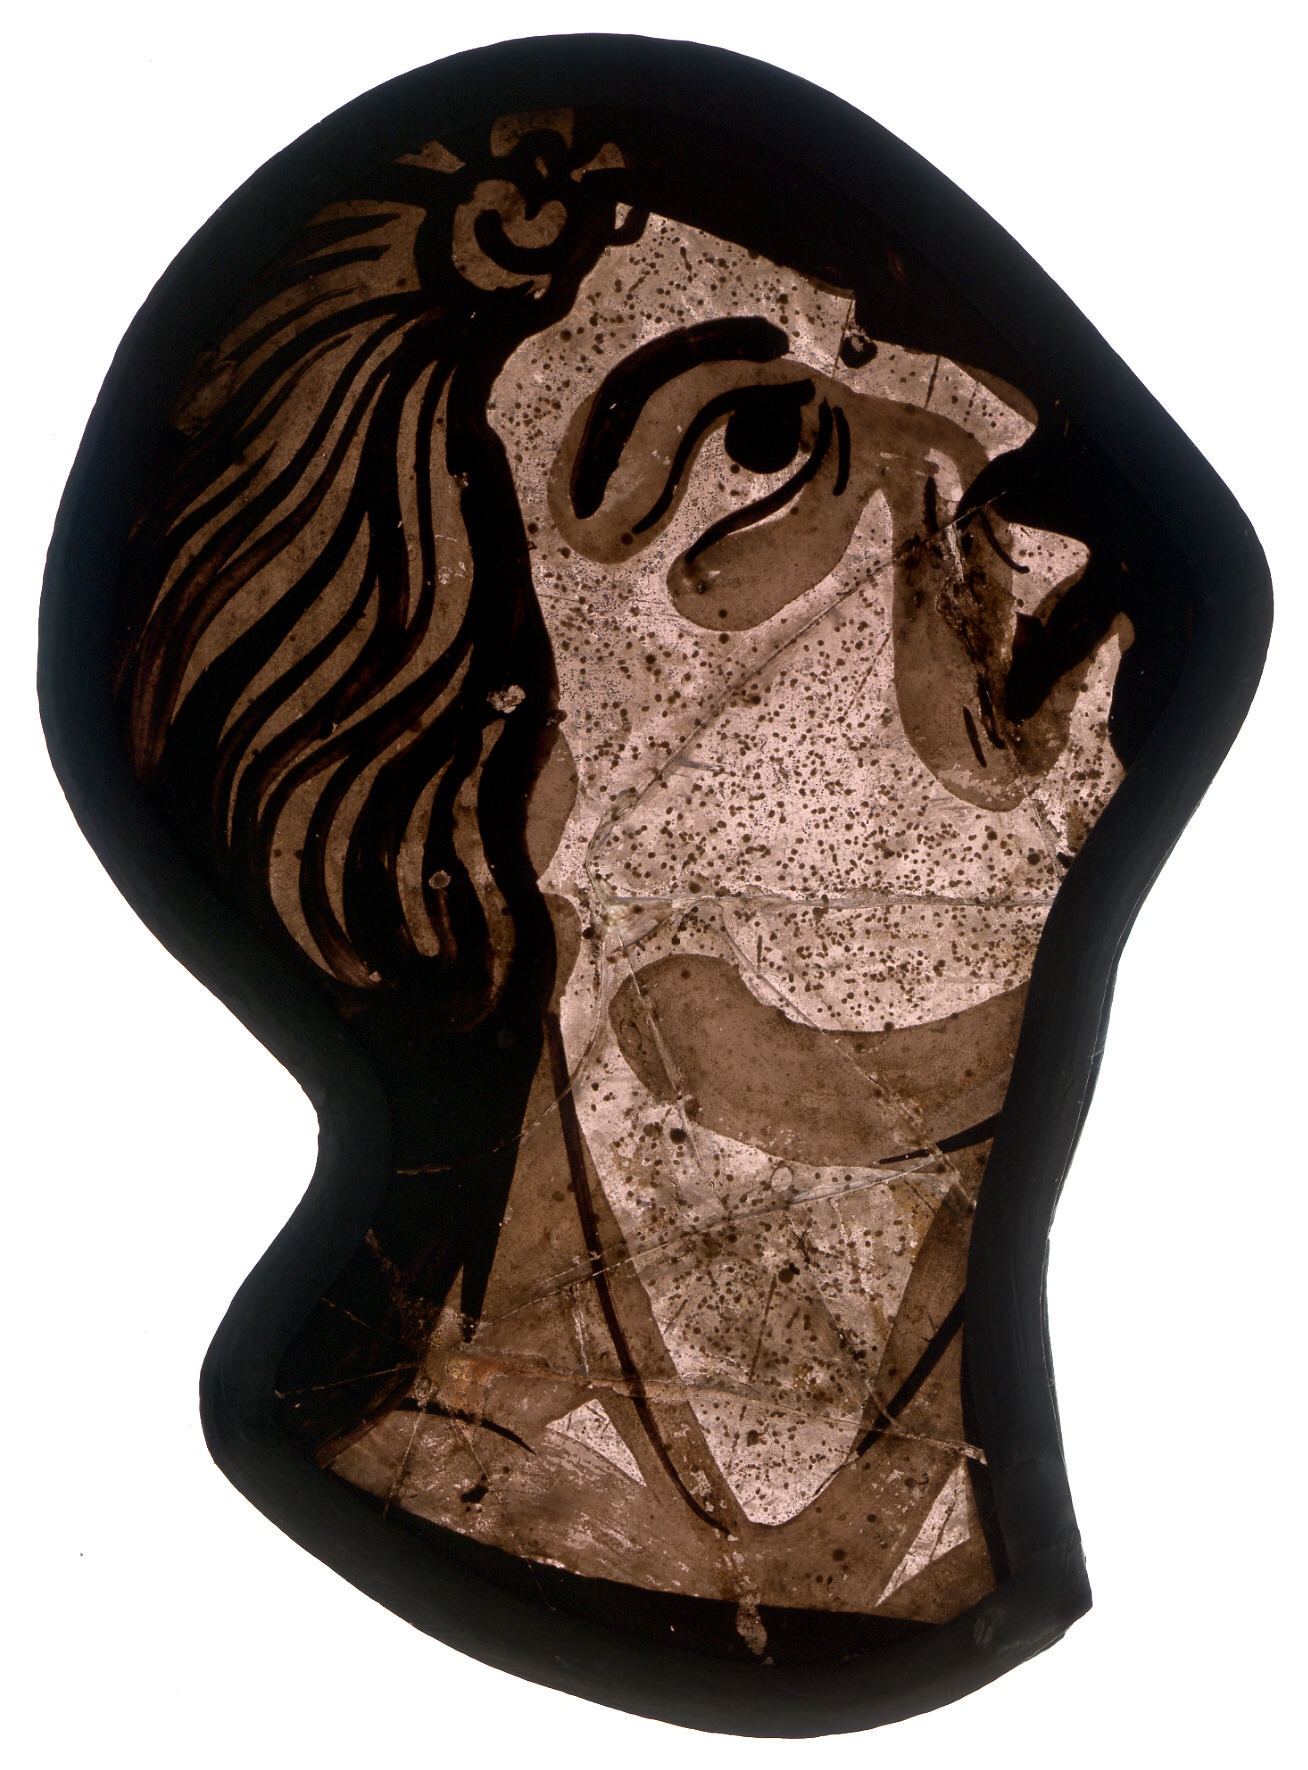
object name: fragment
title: Glass Fragment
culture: french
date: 1200-1215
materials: glass, metal, paint